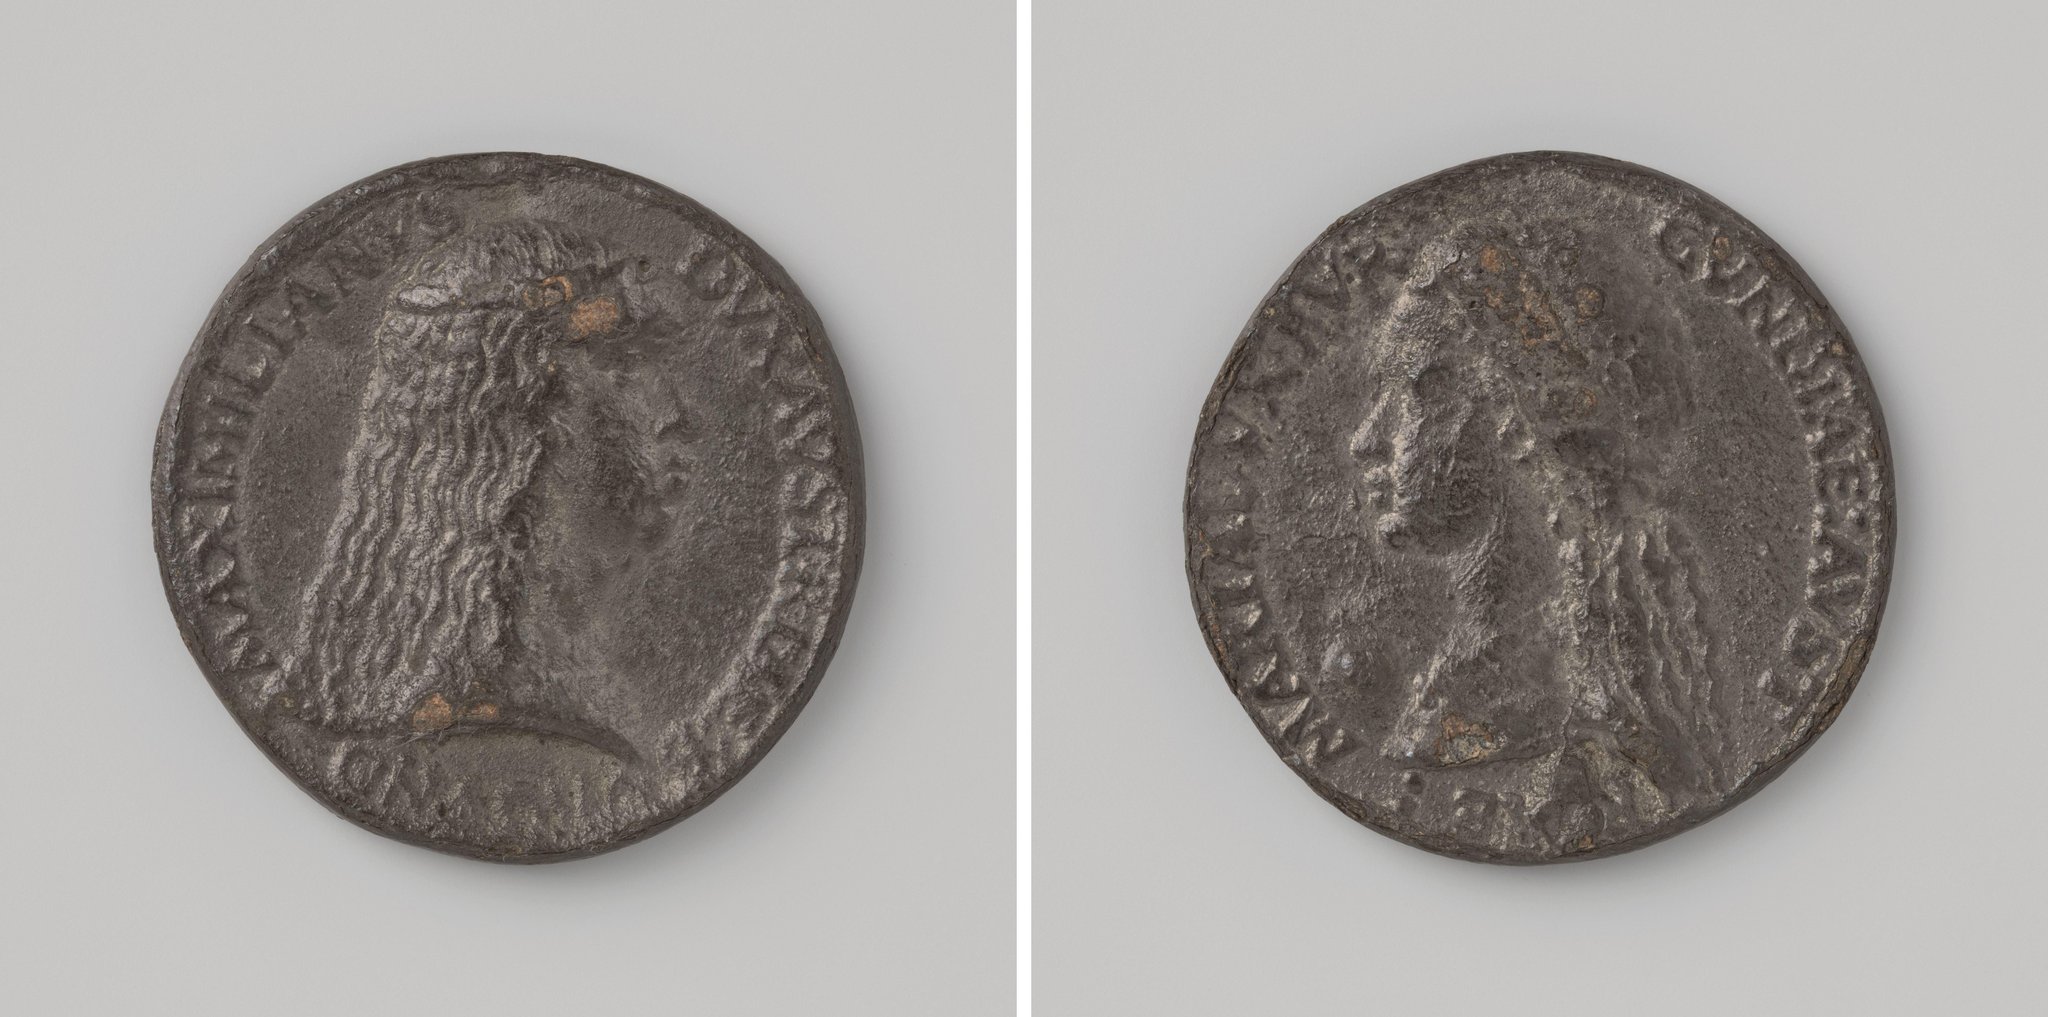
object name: history medal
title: Huwelijk van Maximiliaan van Oostenrijk en Maria van Bourgondië 1477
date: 1477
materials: tin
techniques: casting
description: Tinnen penning, op de voorzijde het portret van Maximiliaan naar rechts met omschrift, op de keerzijde het portret van Maria naar links met omschrift.